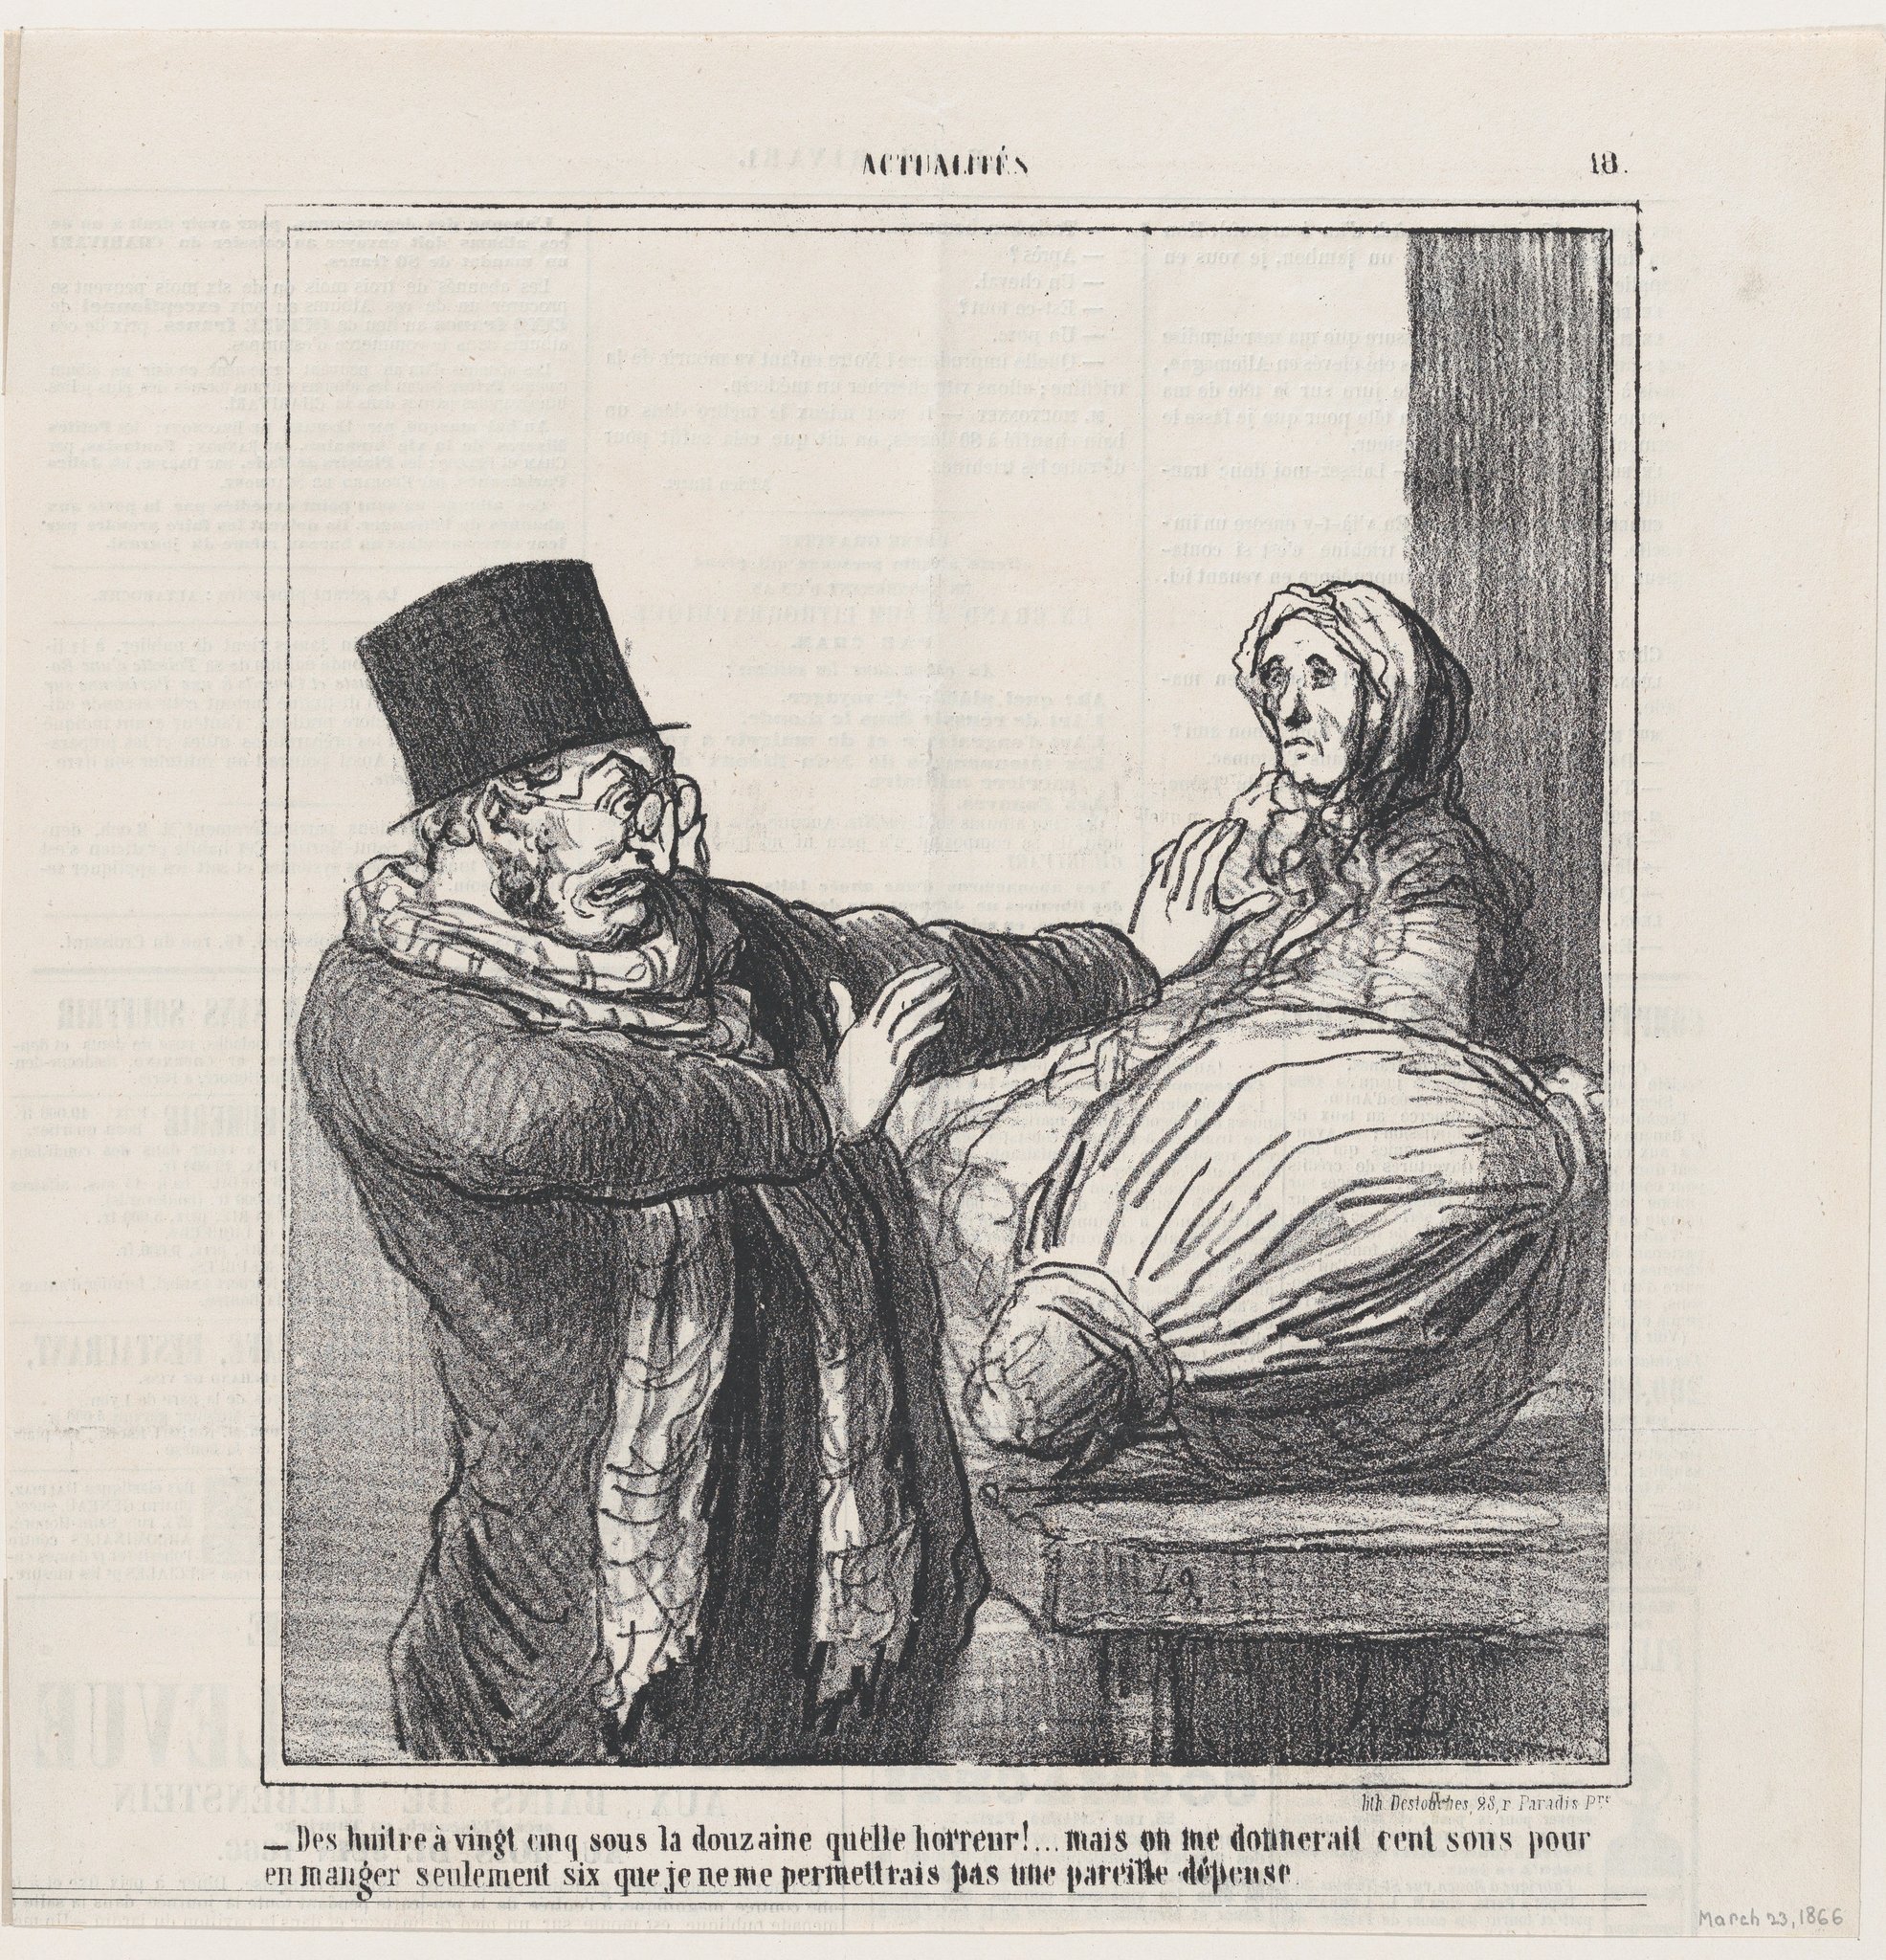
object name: print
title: Oysters at 25 cents a dozen, horrible!... Even if you gave me 100 cents to eat half a dozen, I would not allow myself such an expense, from 'News of the day,' published in Le Charivari, March 23, 1866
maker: honoré daumier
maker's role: artist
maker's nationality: french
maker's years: 1808-1879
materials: paper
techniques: lithograph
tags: men,women,markets